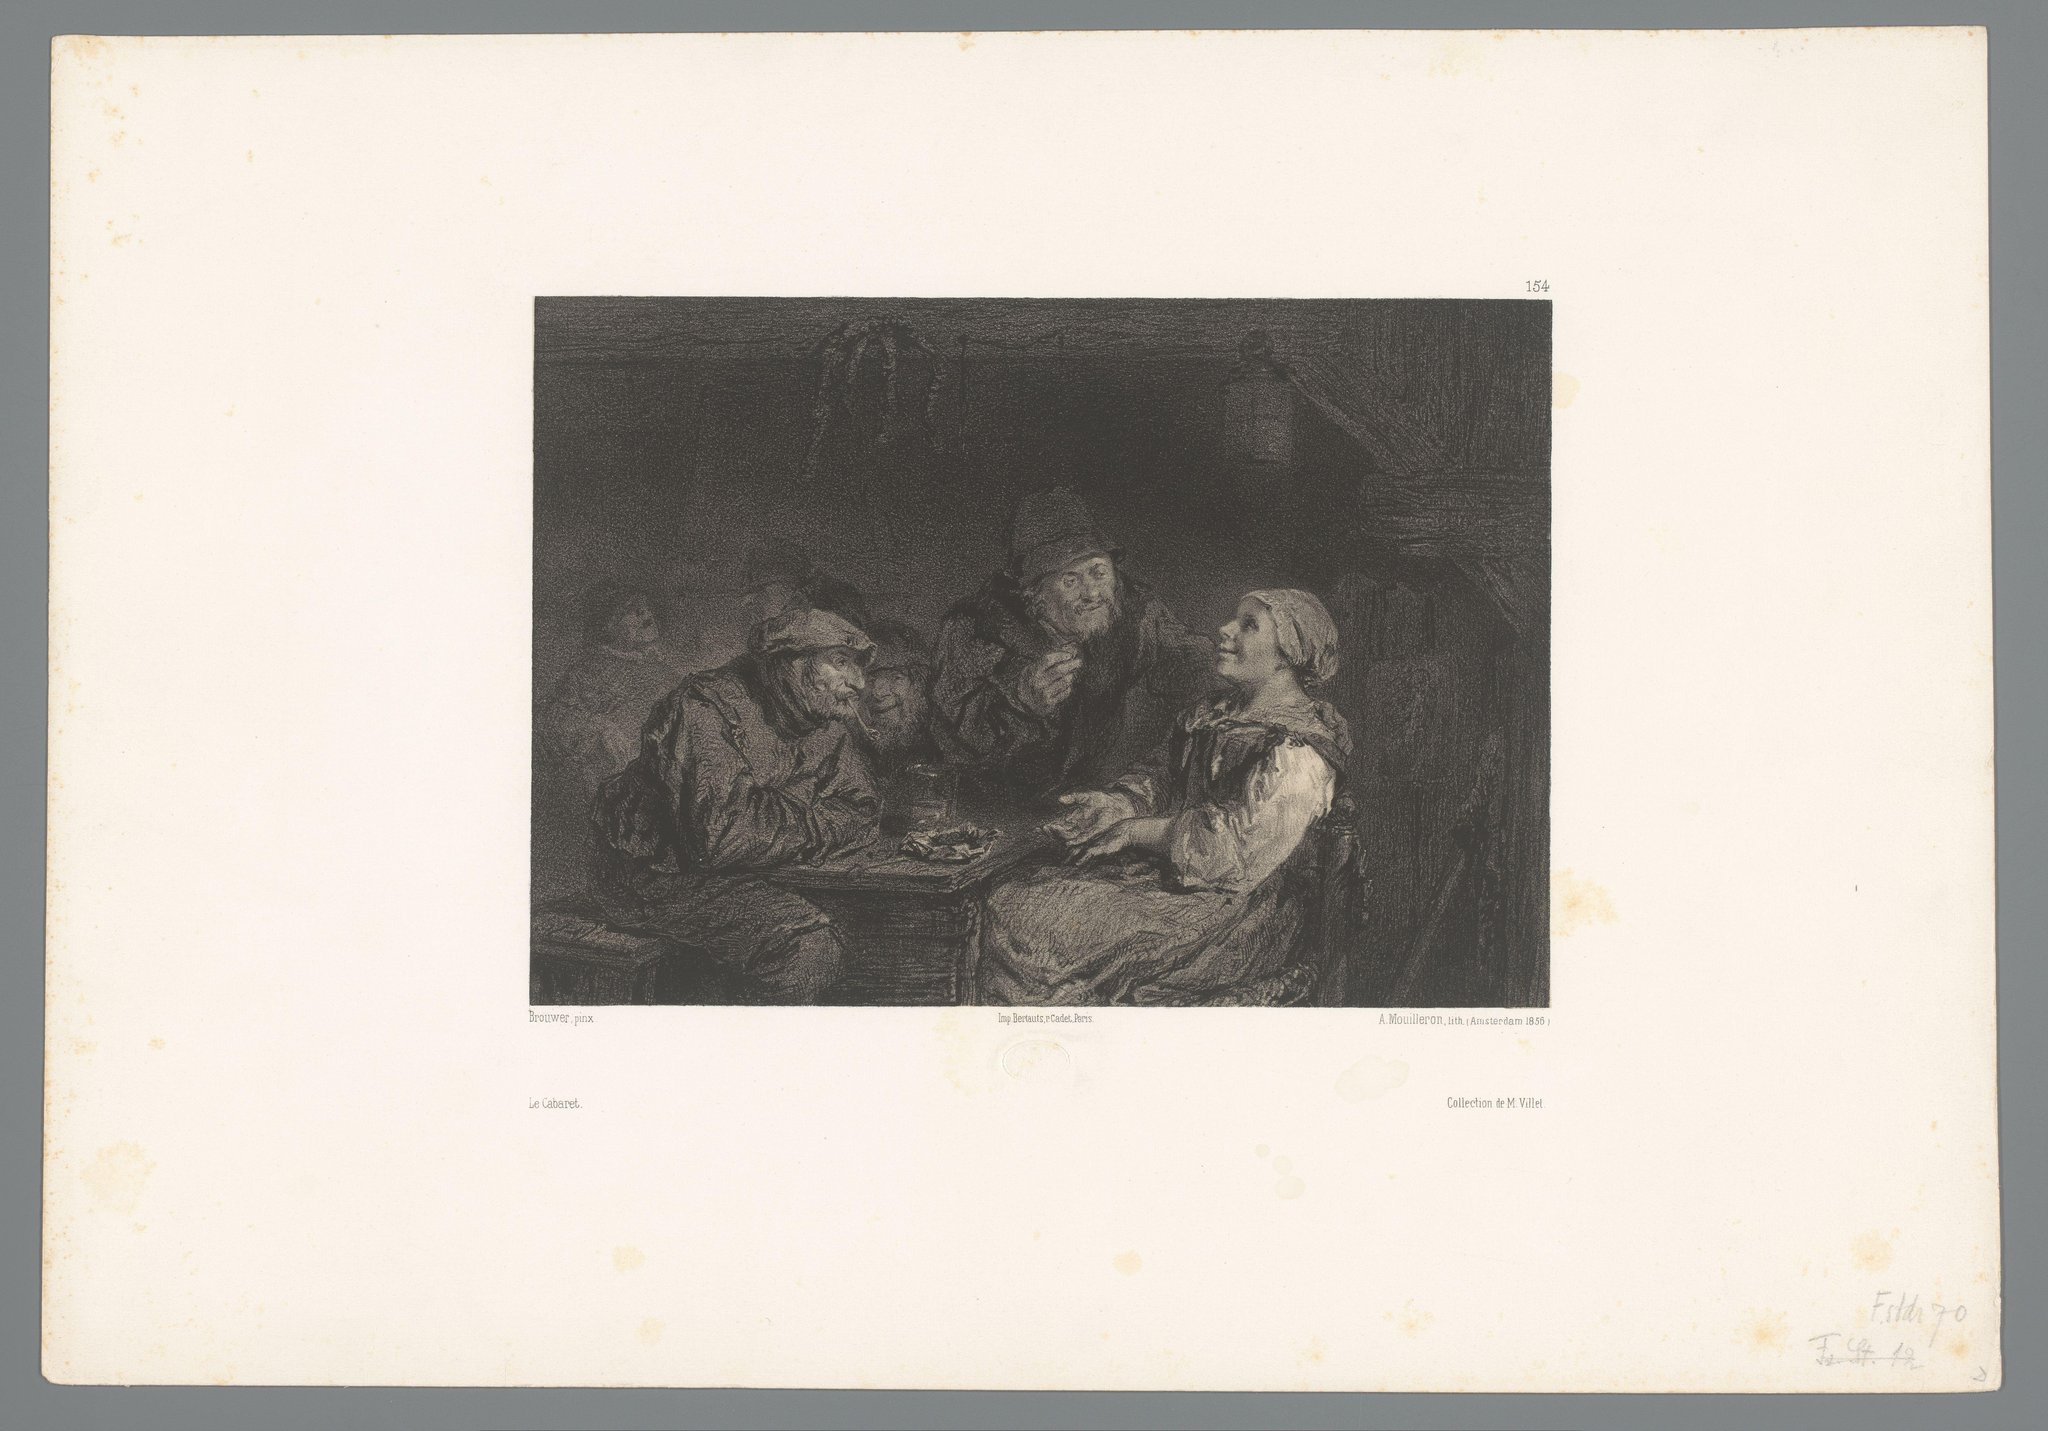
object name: print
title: Le cabaret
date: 1856-1865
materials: paper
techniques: lithograph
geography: paris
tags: adult woman, adult man, inn, coffee-house, public house, etc.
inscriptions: check stamp: Lugt 36a